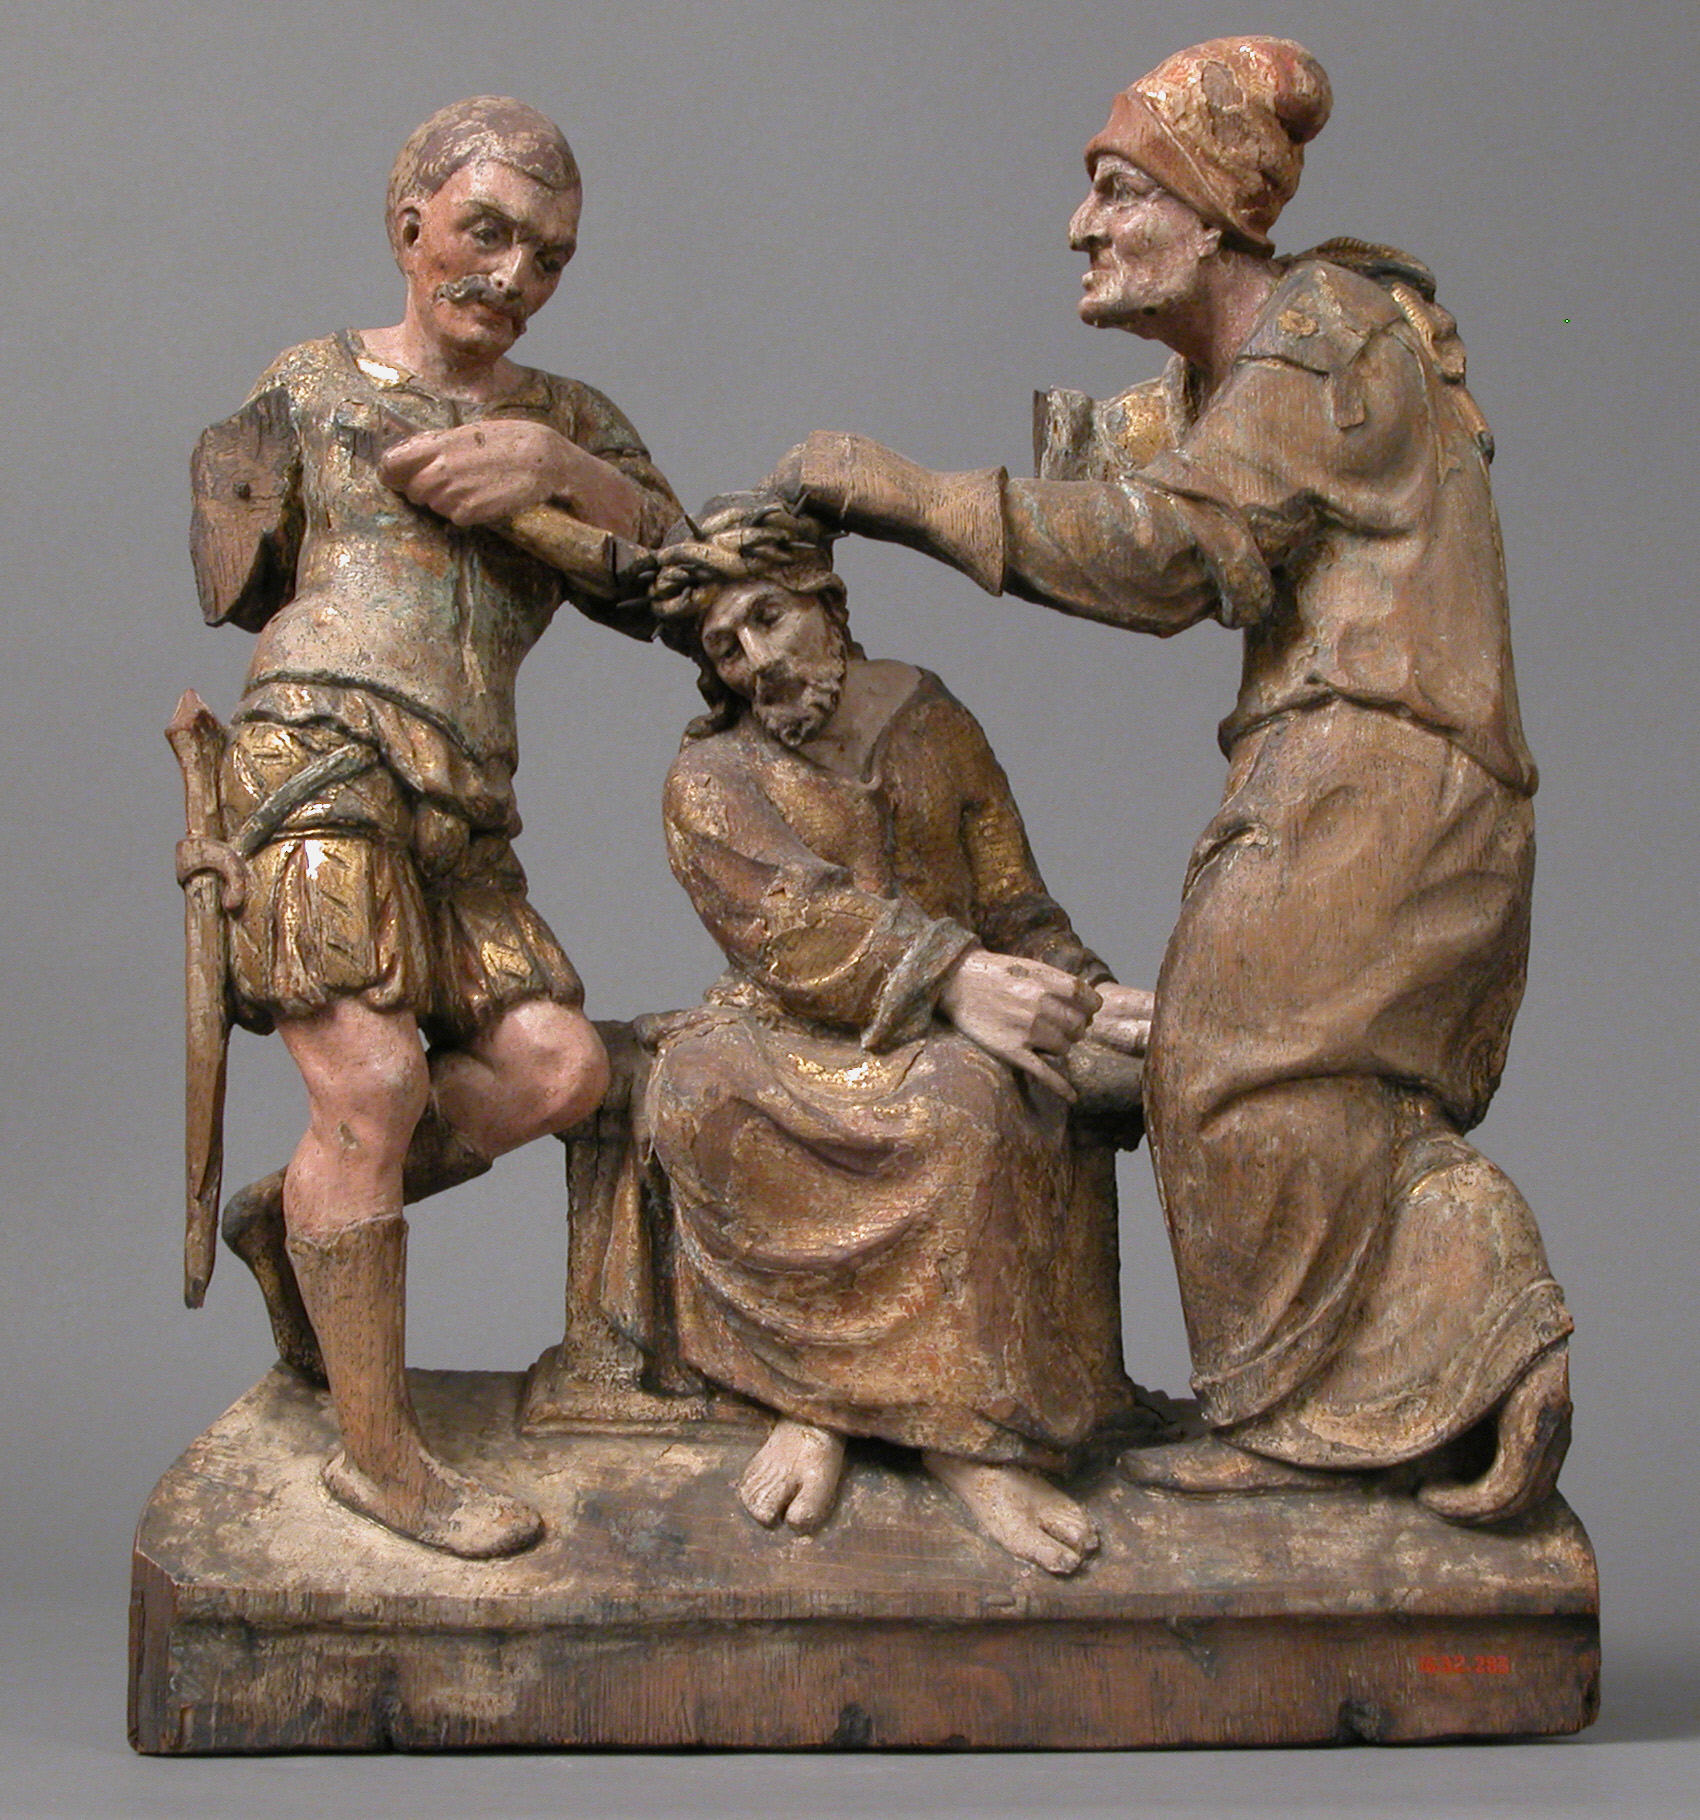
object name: relief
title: Christ Crowned with Thorns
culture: south netherlandish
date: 1501-1533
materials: wood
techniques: gilding, polychromy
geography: antwerp (?)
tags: men,christ